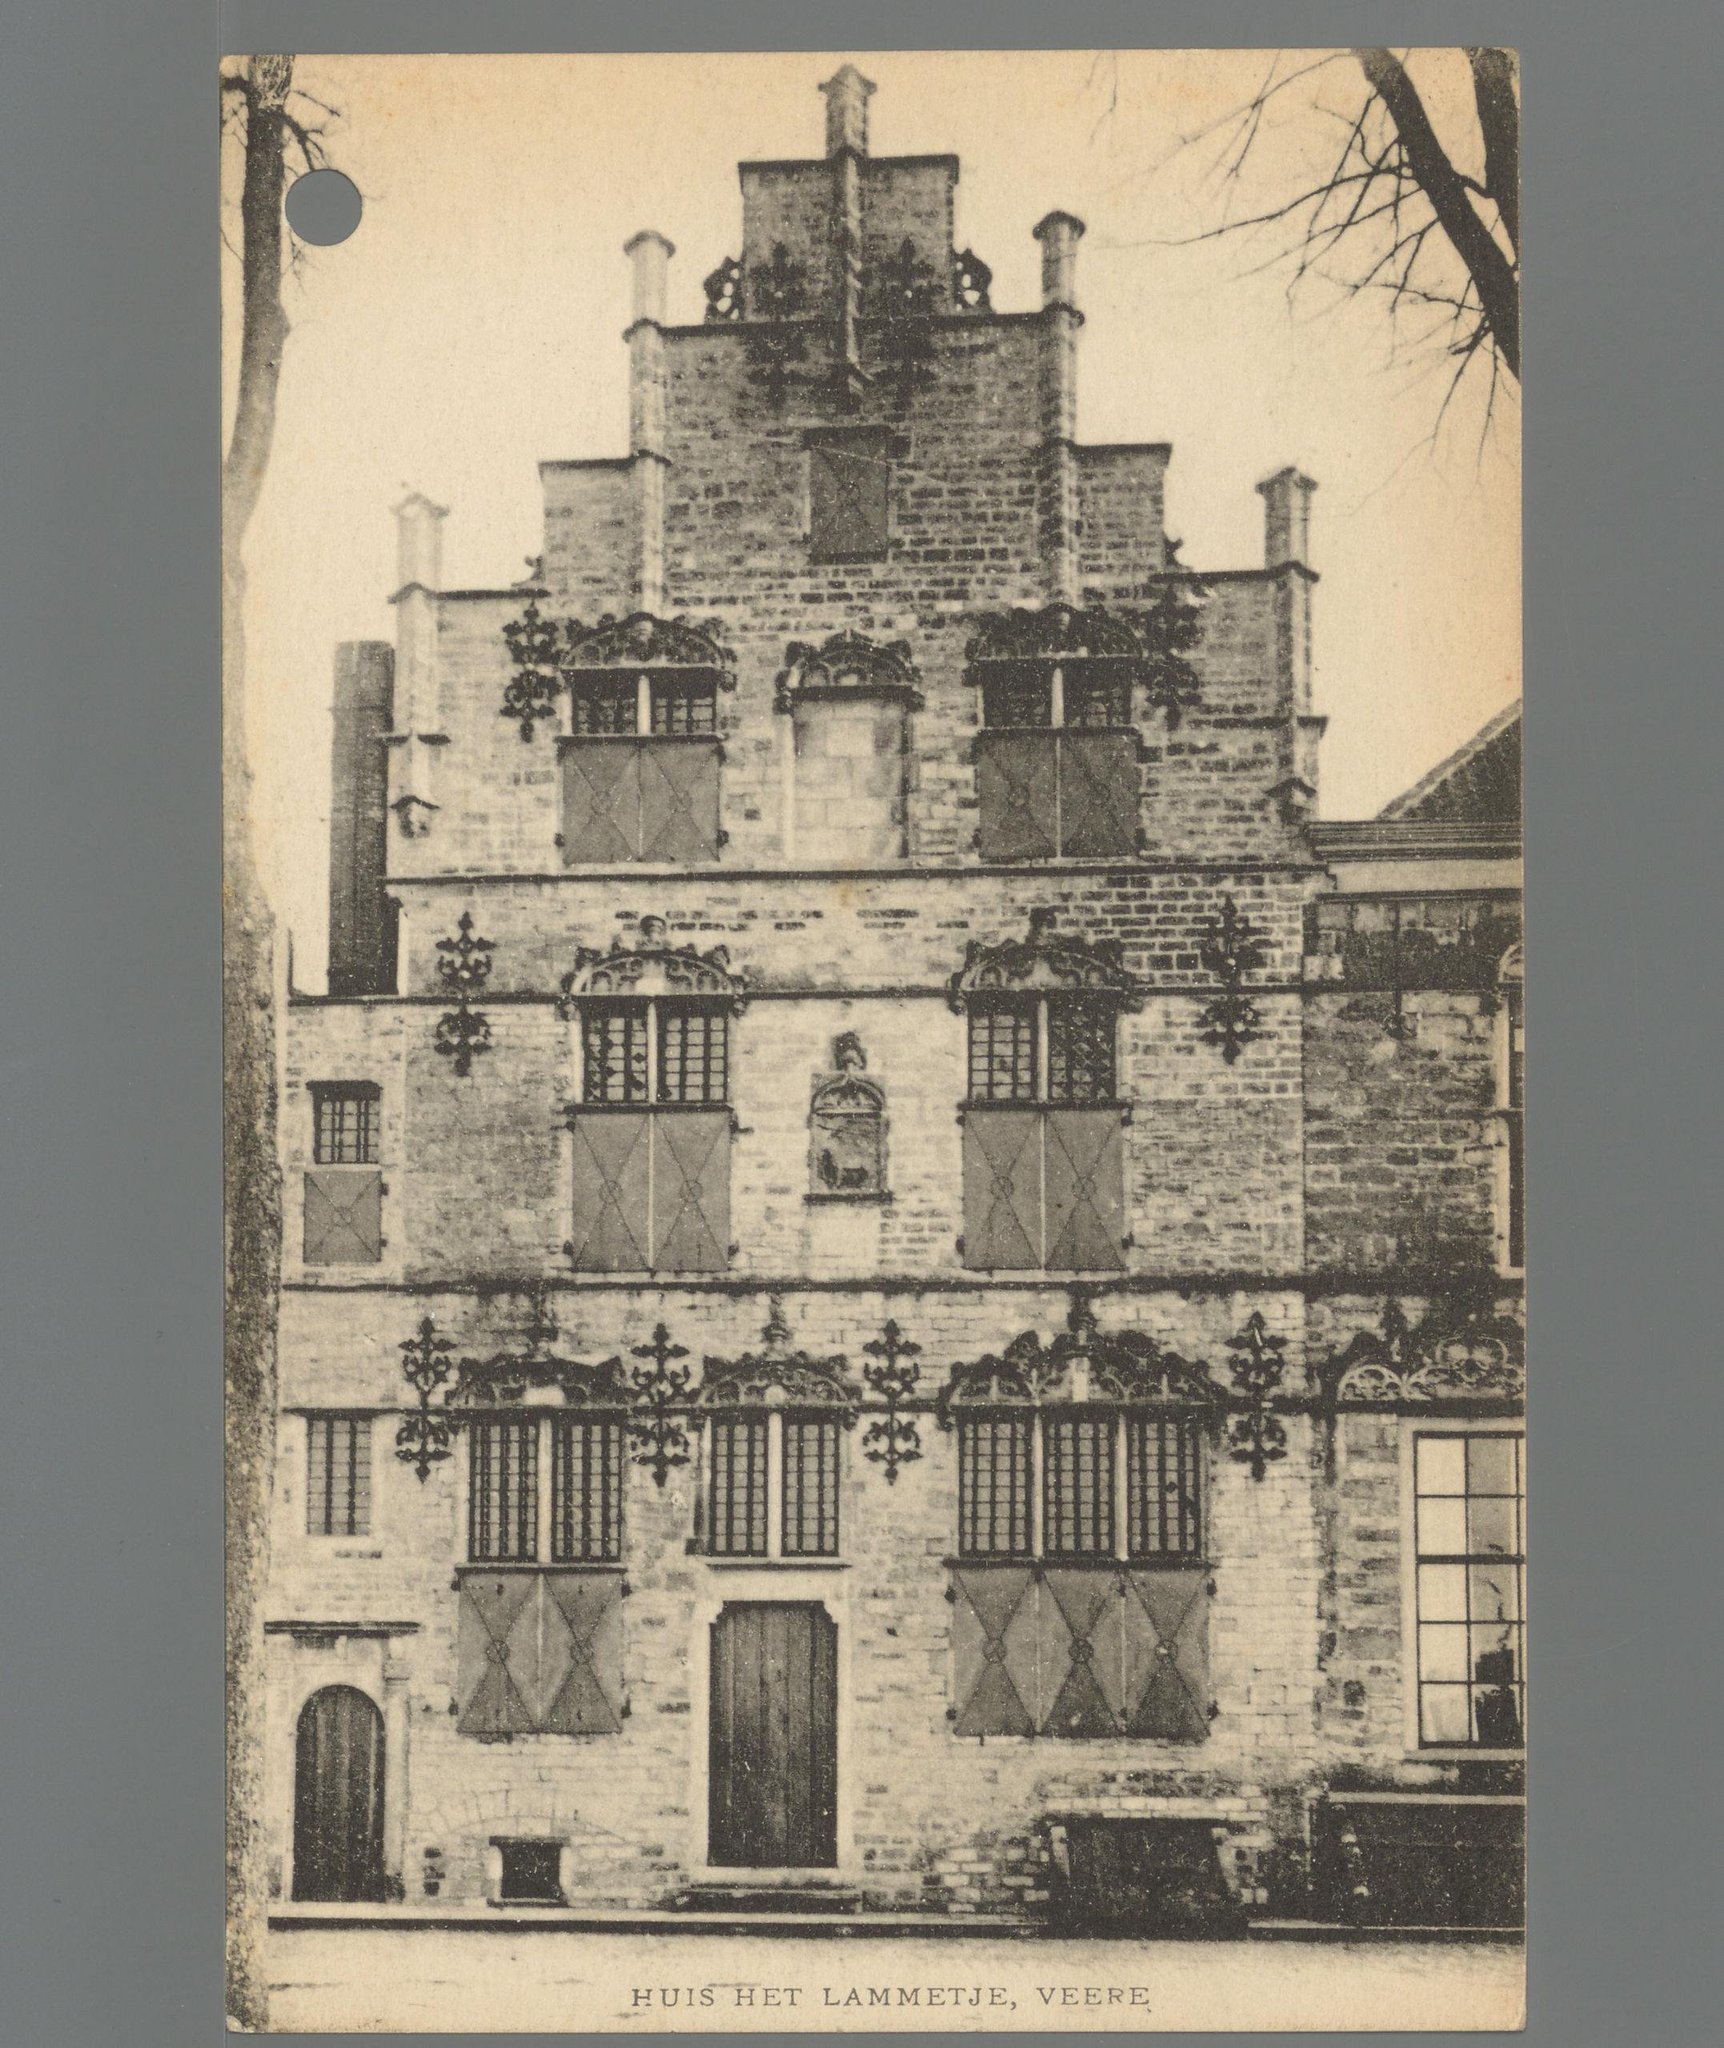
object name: ansichtkaart, prentbriefkaart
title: Huis het Lammetje, Veere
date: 1906-1930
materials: cardboard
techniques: photograph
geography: veere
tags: façade (of house or building)